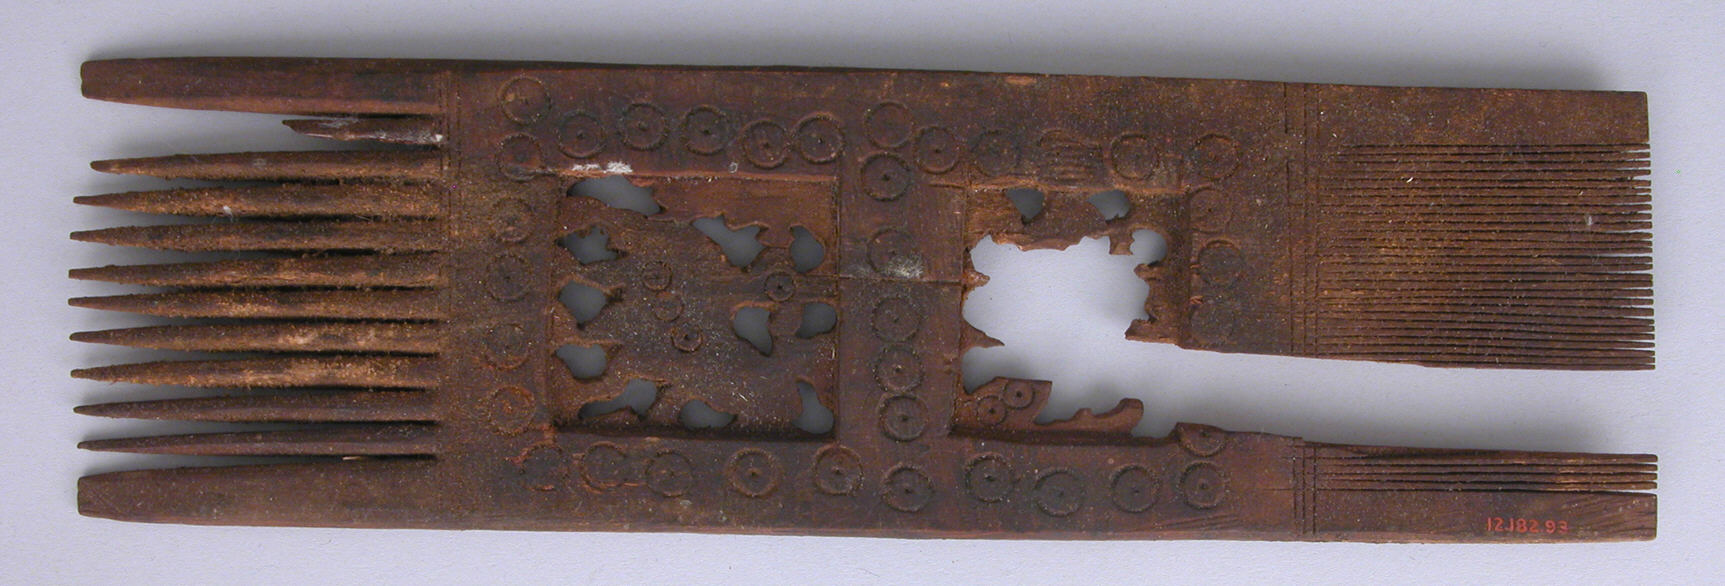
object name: comb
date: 601-800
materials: wood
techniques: carving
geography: egypt